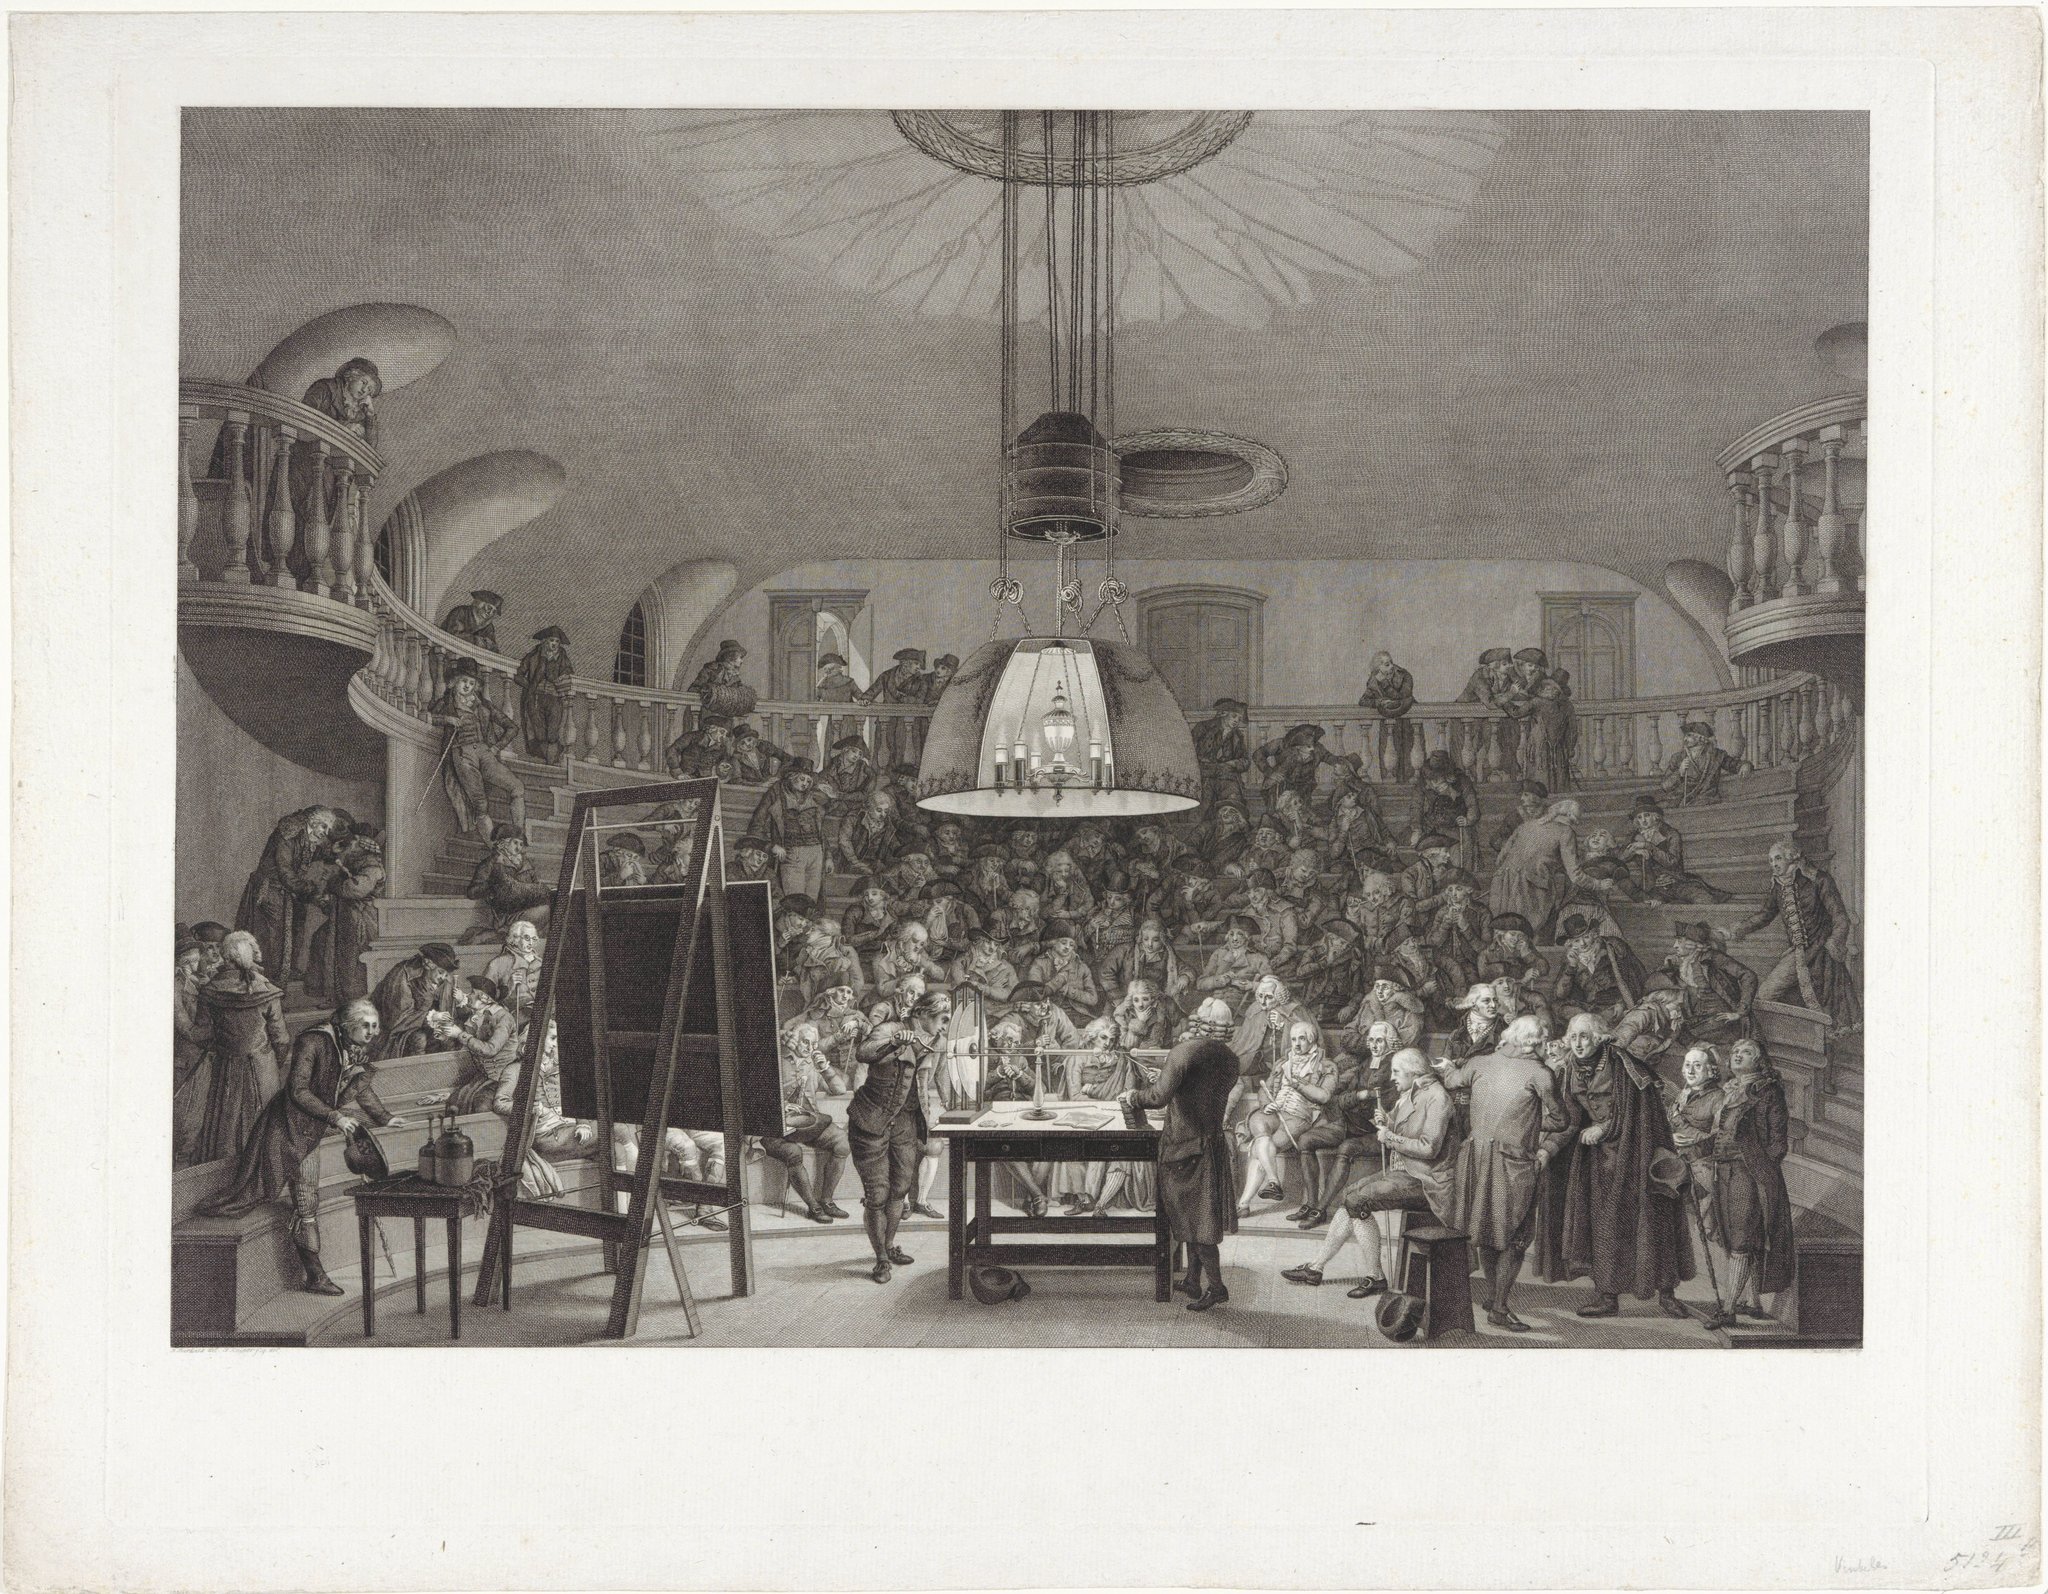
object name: print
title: Zaal der Natuurkunde in Felix Meritis, 1789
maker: reinier vinkeles (i)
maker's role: draughtsman, print maker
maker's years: 1741-1816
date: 1801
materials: paper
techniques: engraving, etching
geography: amsterdam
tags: physics, learned society, academy of sciences, physics (+ tools, instruments; laboratory equipment ~ scientific research), amsterdam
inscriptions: collector's mark: Lugt 2228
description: Demonstratie van de elektriseermachine in de Zaal der Natuurkunde in het gebouw van de maatschappij Felix Meritis te Amsterdam, ingewijd in 1789.